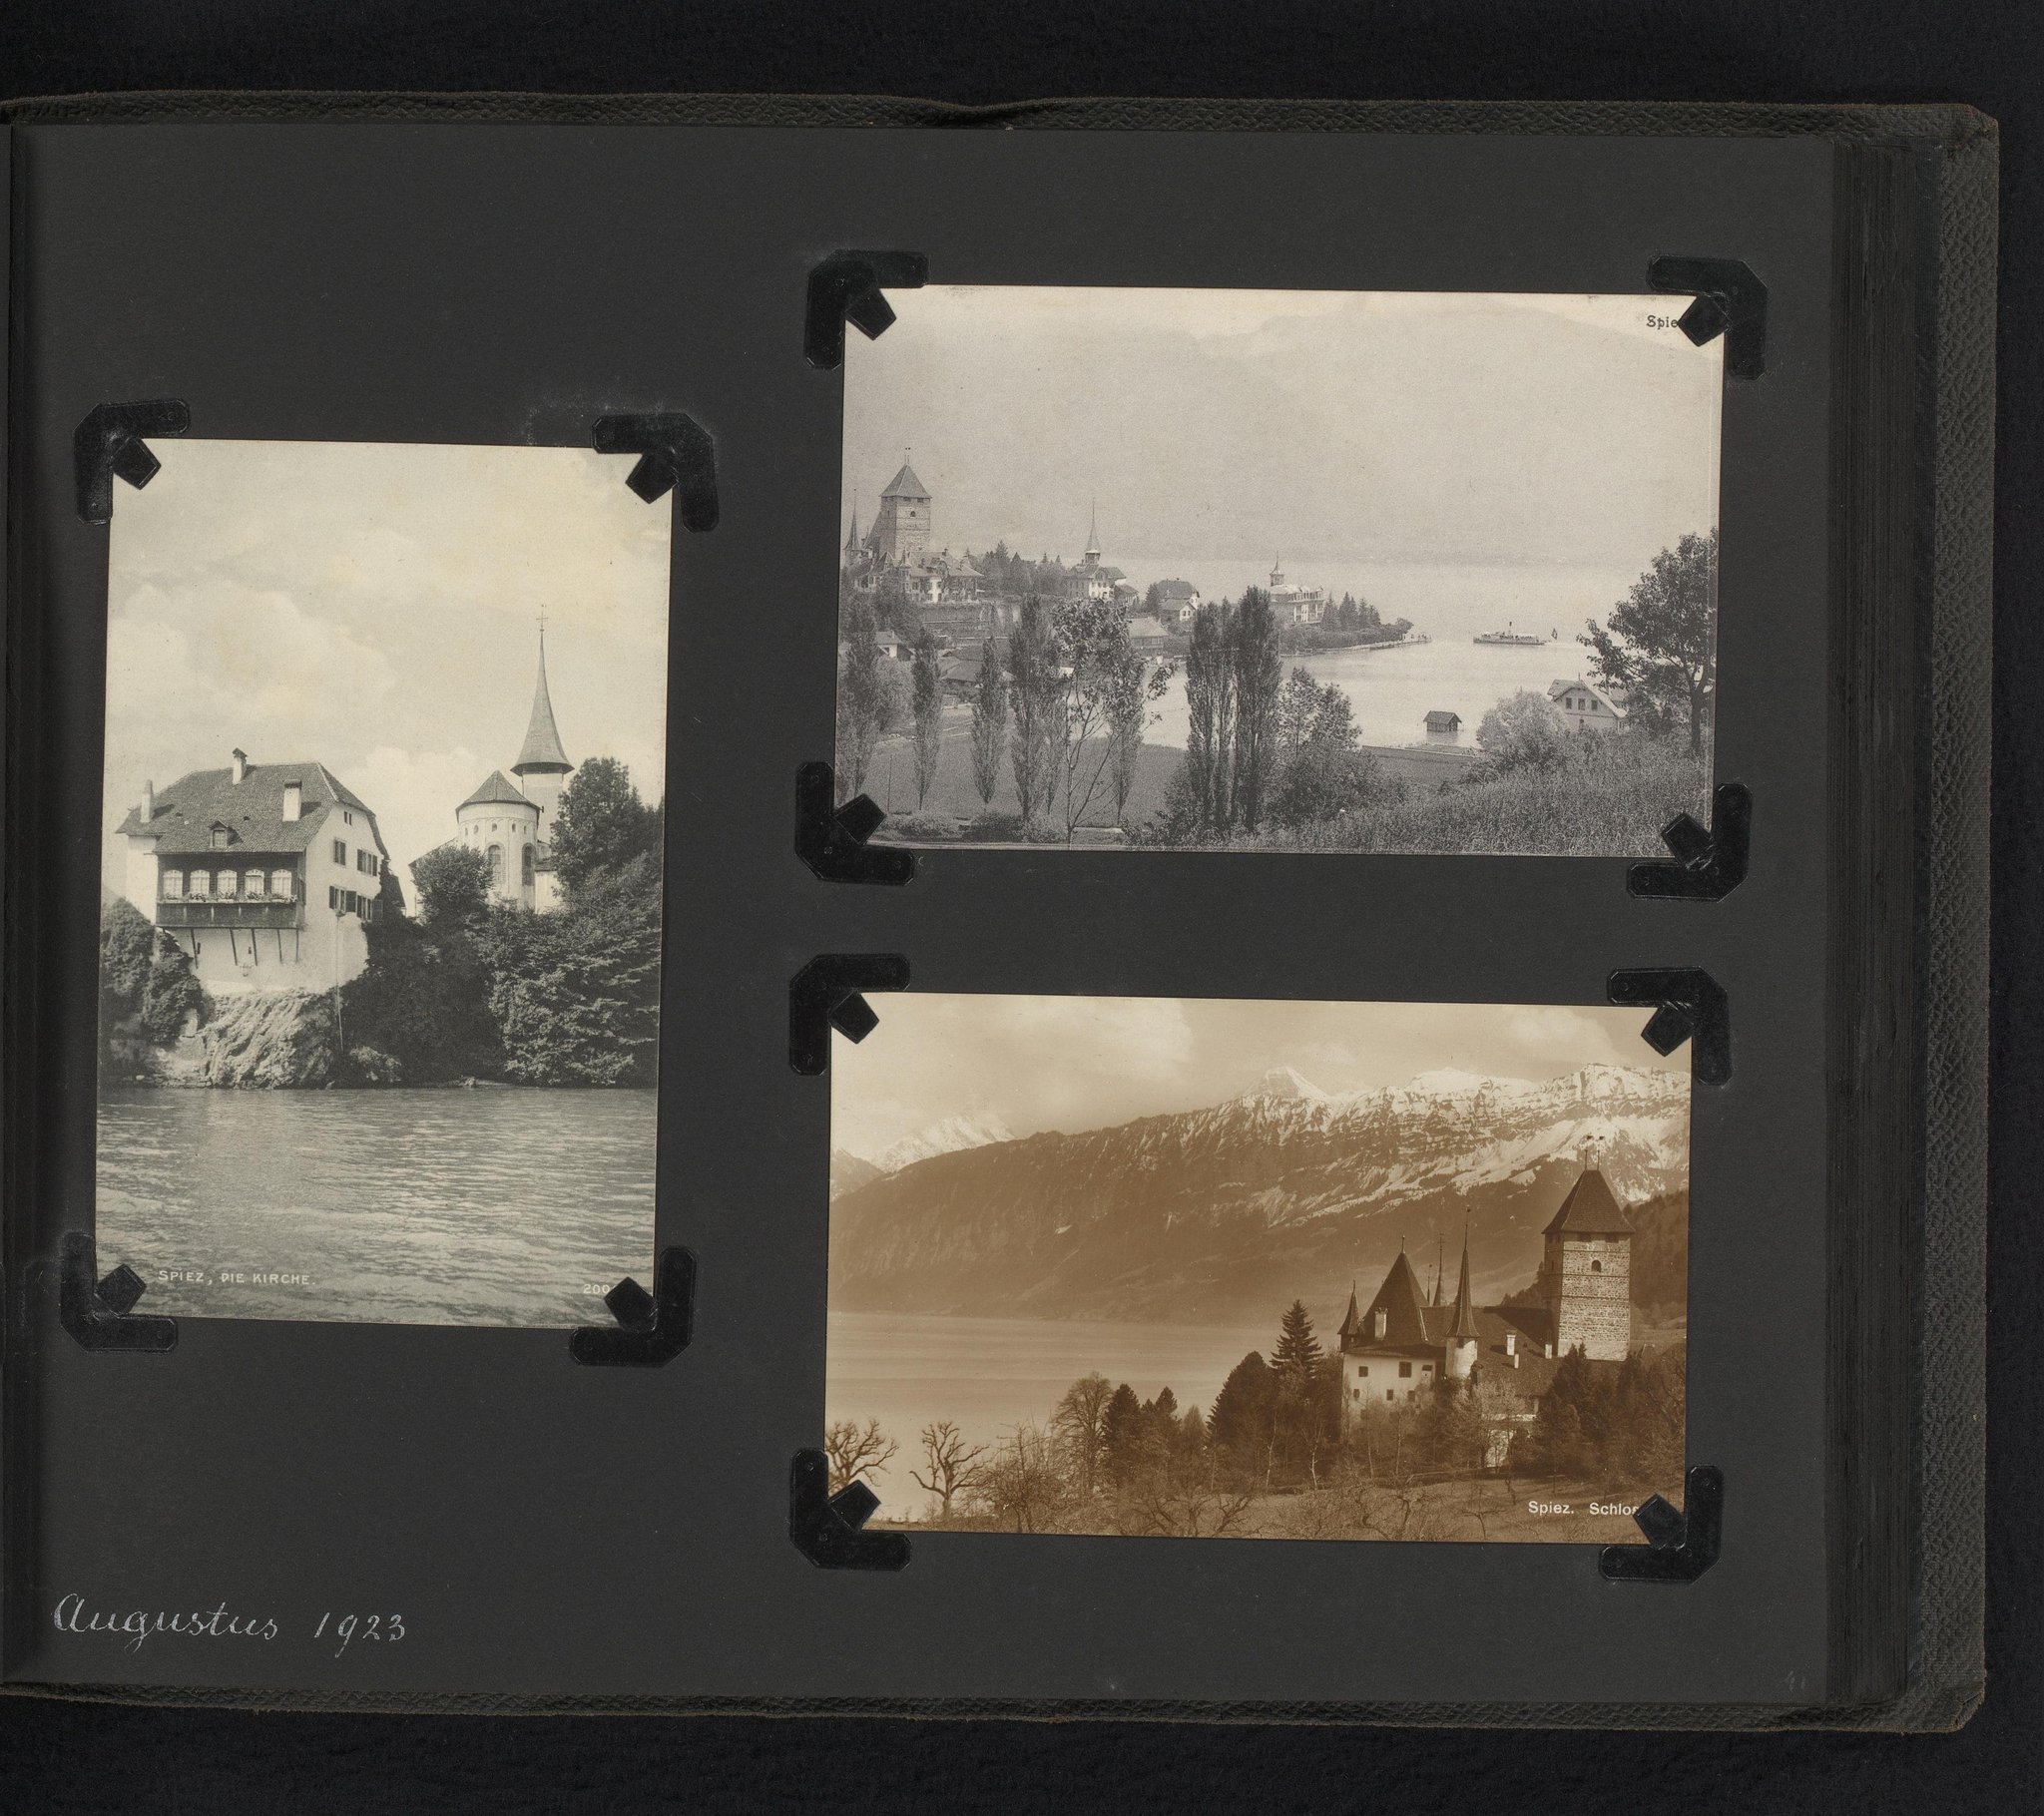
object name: album leaf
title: Augustus 1923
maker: Anonymous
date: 1908-1923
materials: paper, cardboard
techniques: photograph, gelatin silver print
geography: bern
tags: village, lake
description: Deze prenten en foto maken deel uit van een album.